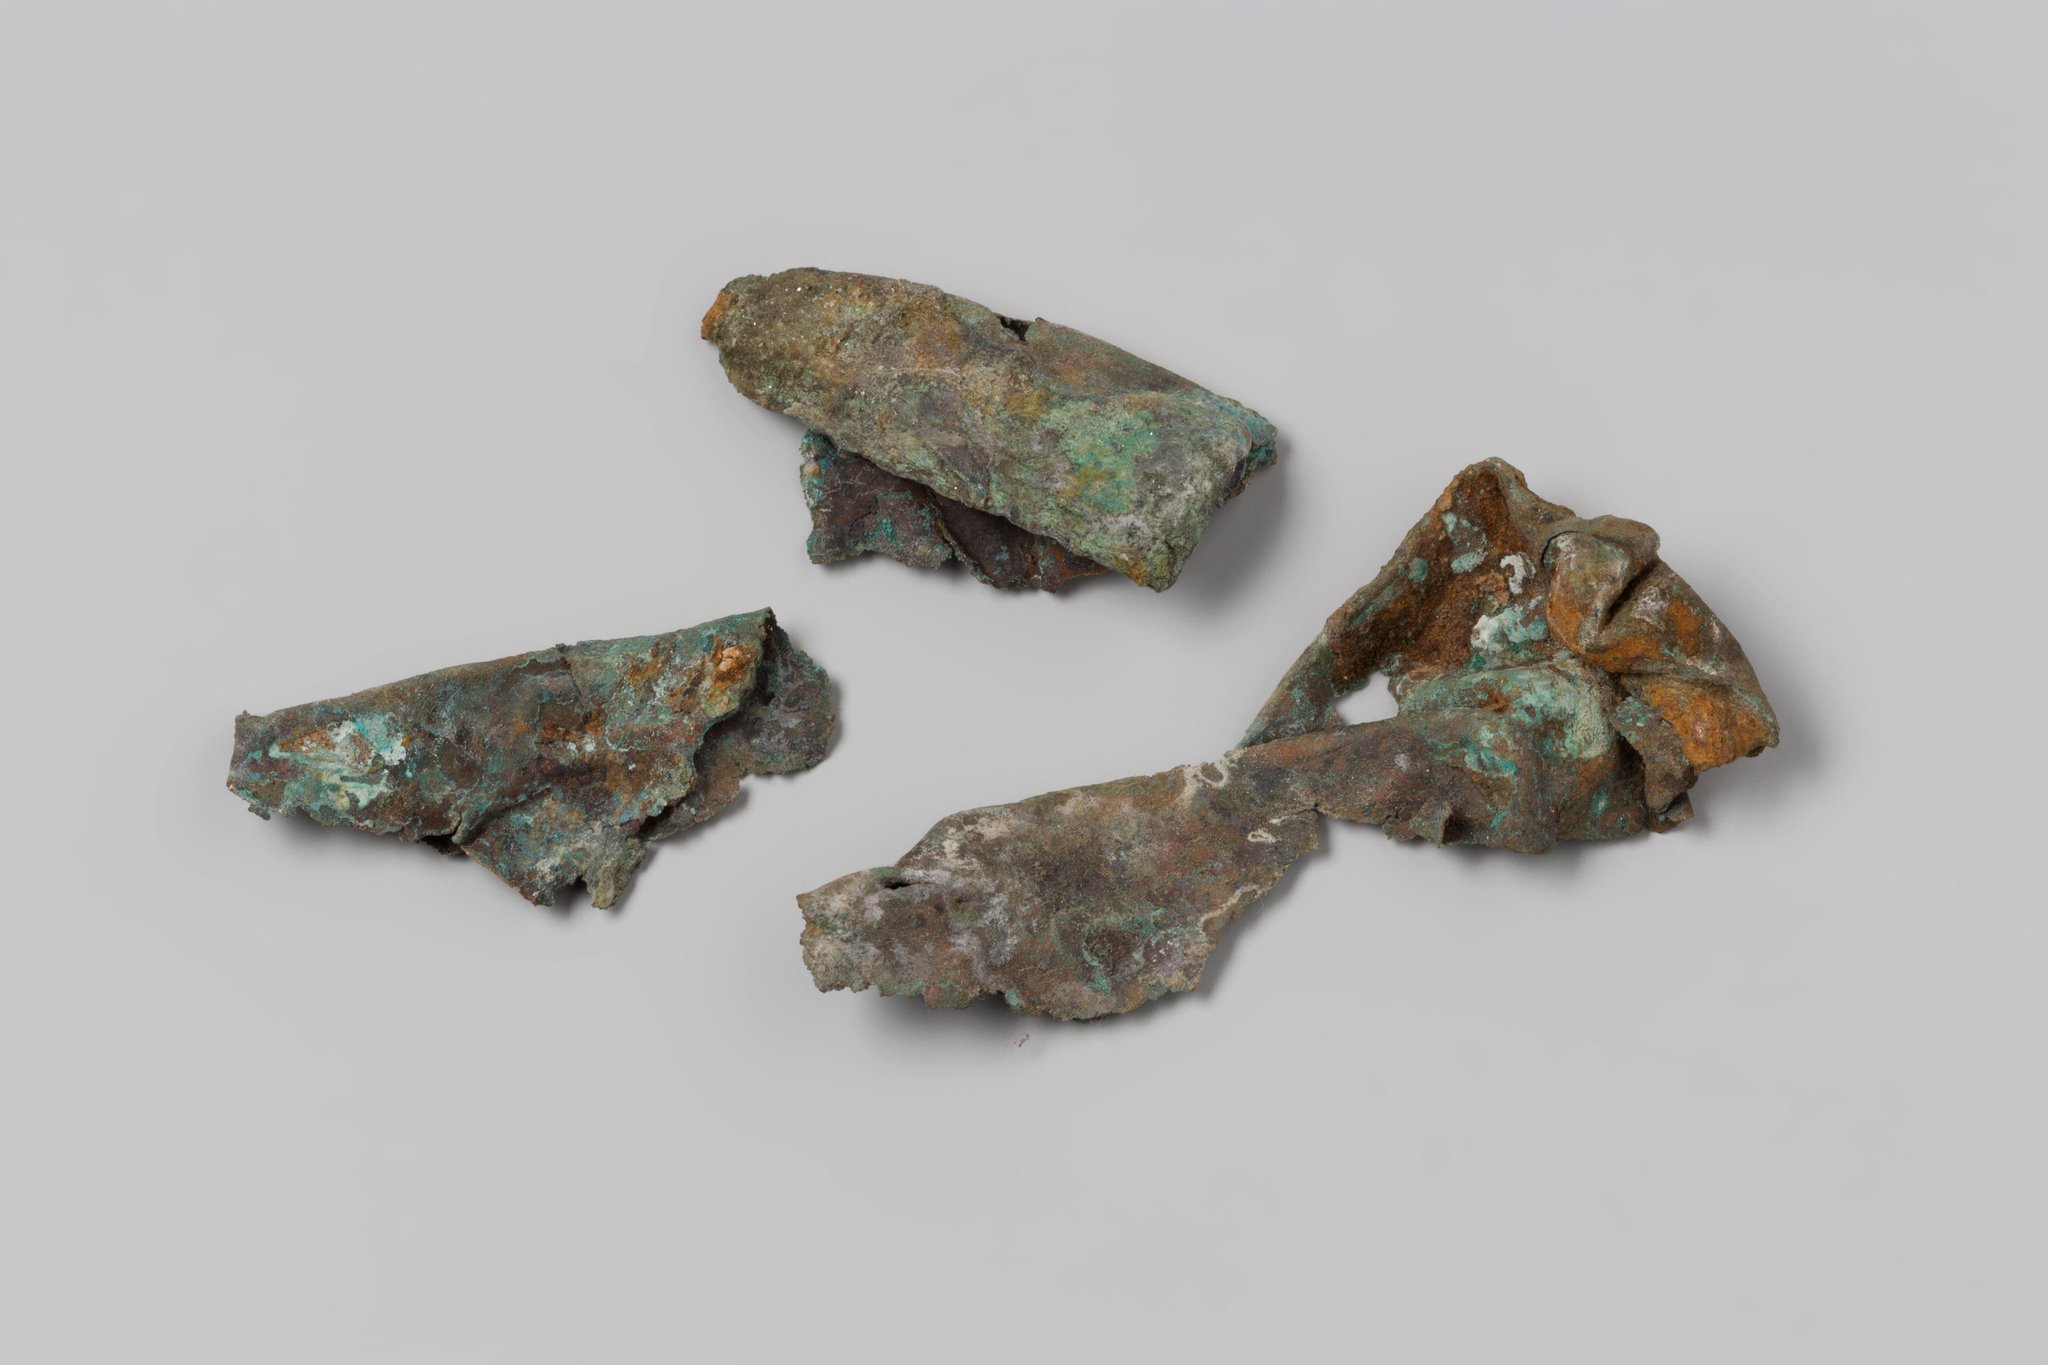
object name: scheepswrakvondst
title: Fragmenten van koper uit het wrak van de Oost-Indiëvaarder Hollandia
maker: Anonymous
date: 1700-1743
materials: copper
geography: netherlands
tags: verenigde oostindische compagnie, hollandia (schip), annet